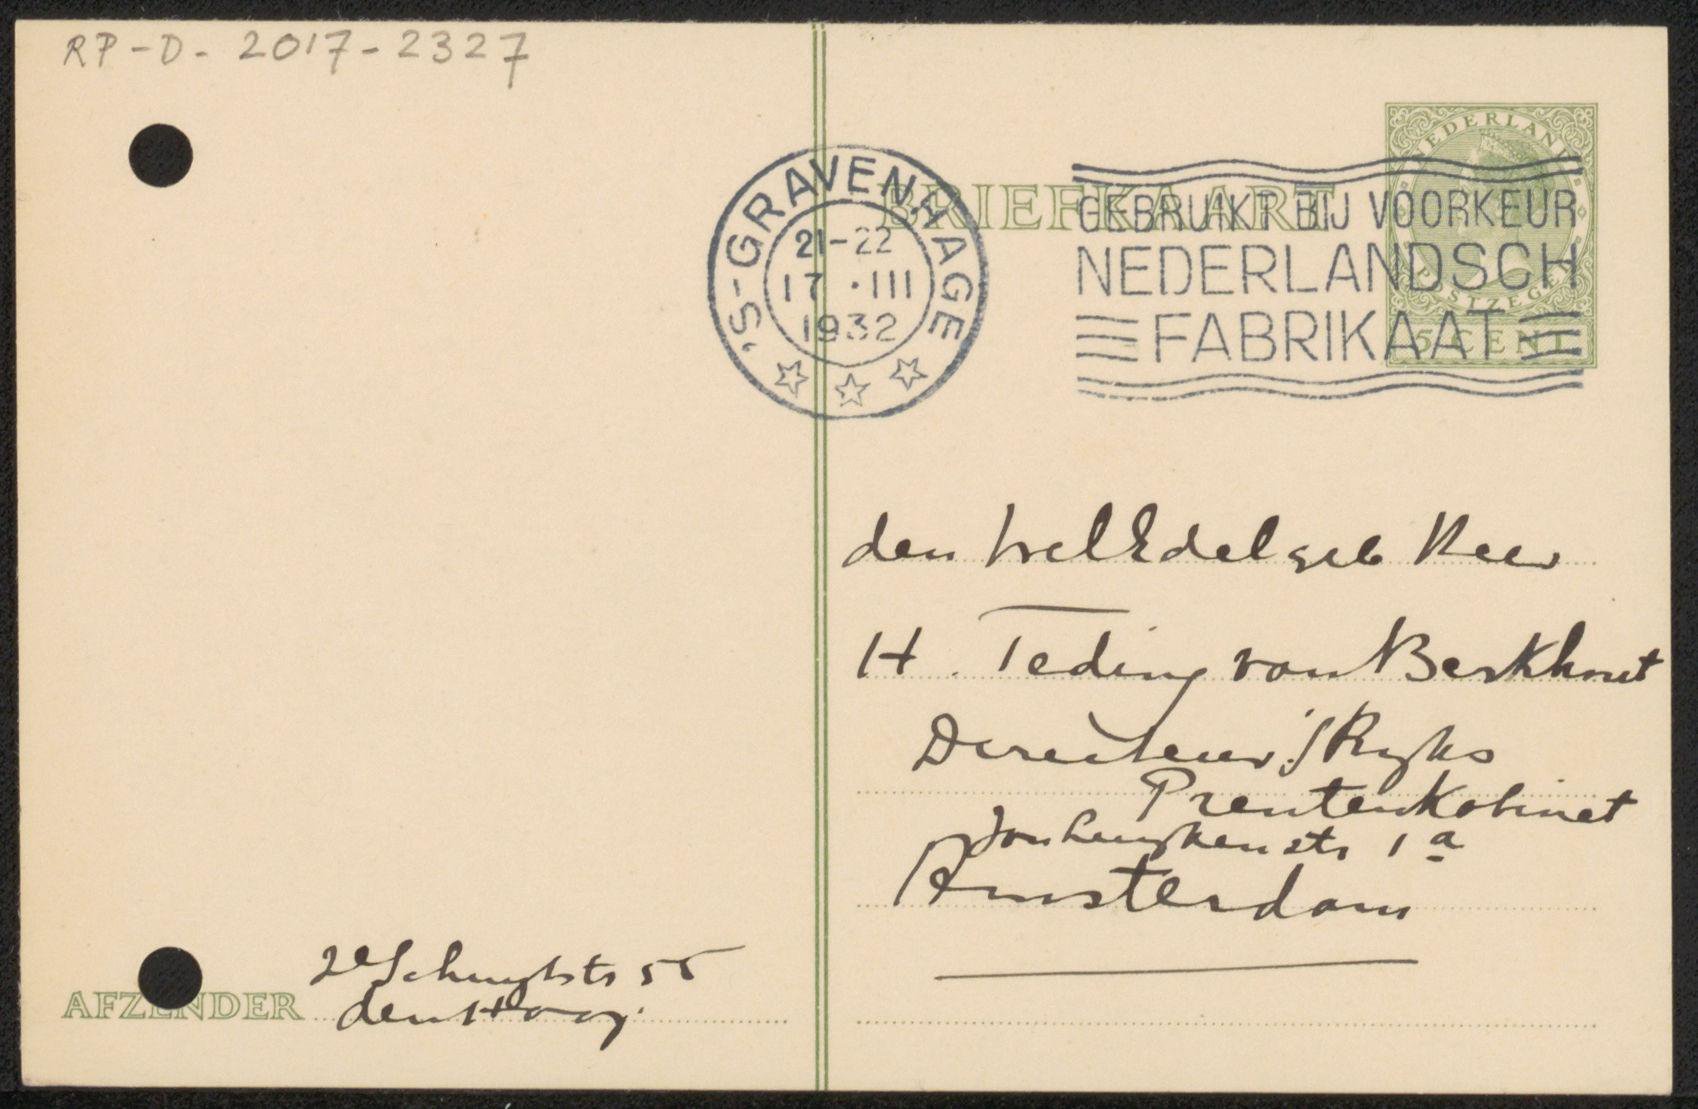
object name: postcard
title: Briefkaart aan jonkheer Hendrik Teding van Berkhout (1879-1969)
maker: henri verstijnen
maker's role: draughtsman, print maker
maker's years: 1882-1940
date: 1932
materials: cardboard, ink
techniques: pen, writing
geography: the hague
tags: haarlem, amsterdam, jonkheer hendrik teding van berkhout (1879-1969), maastricht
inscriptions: watermark